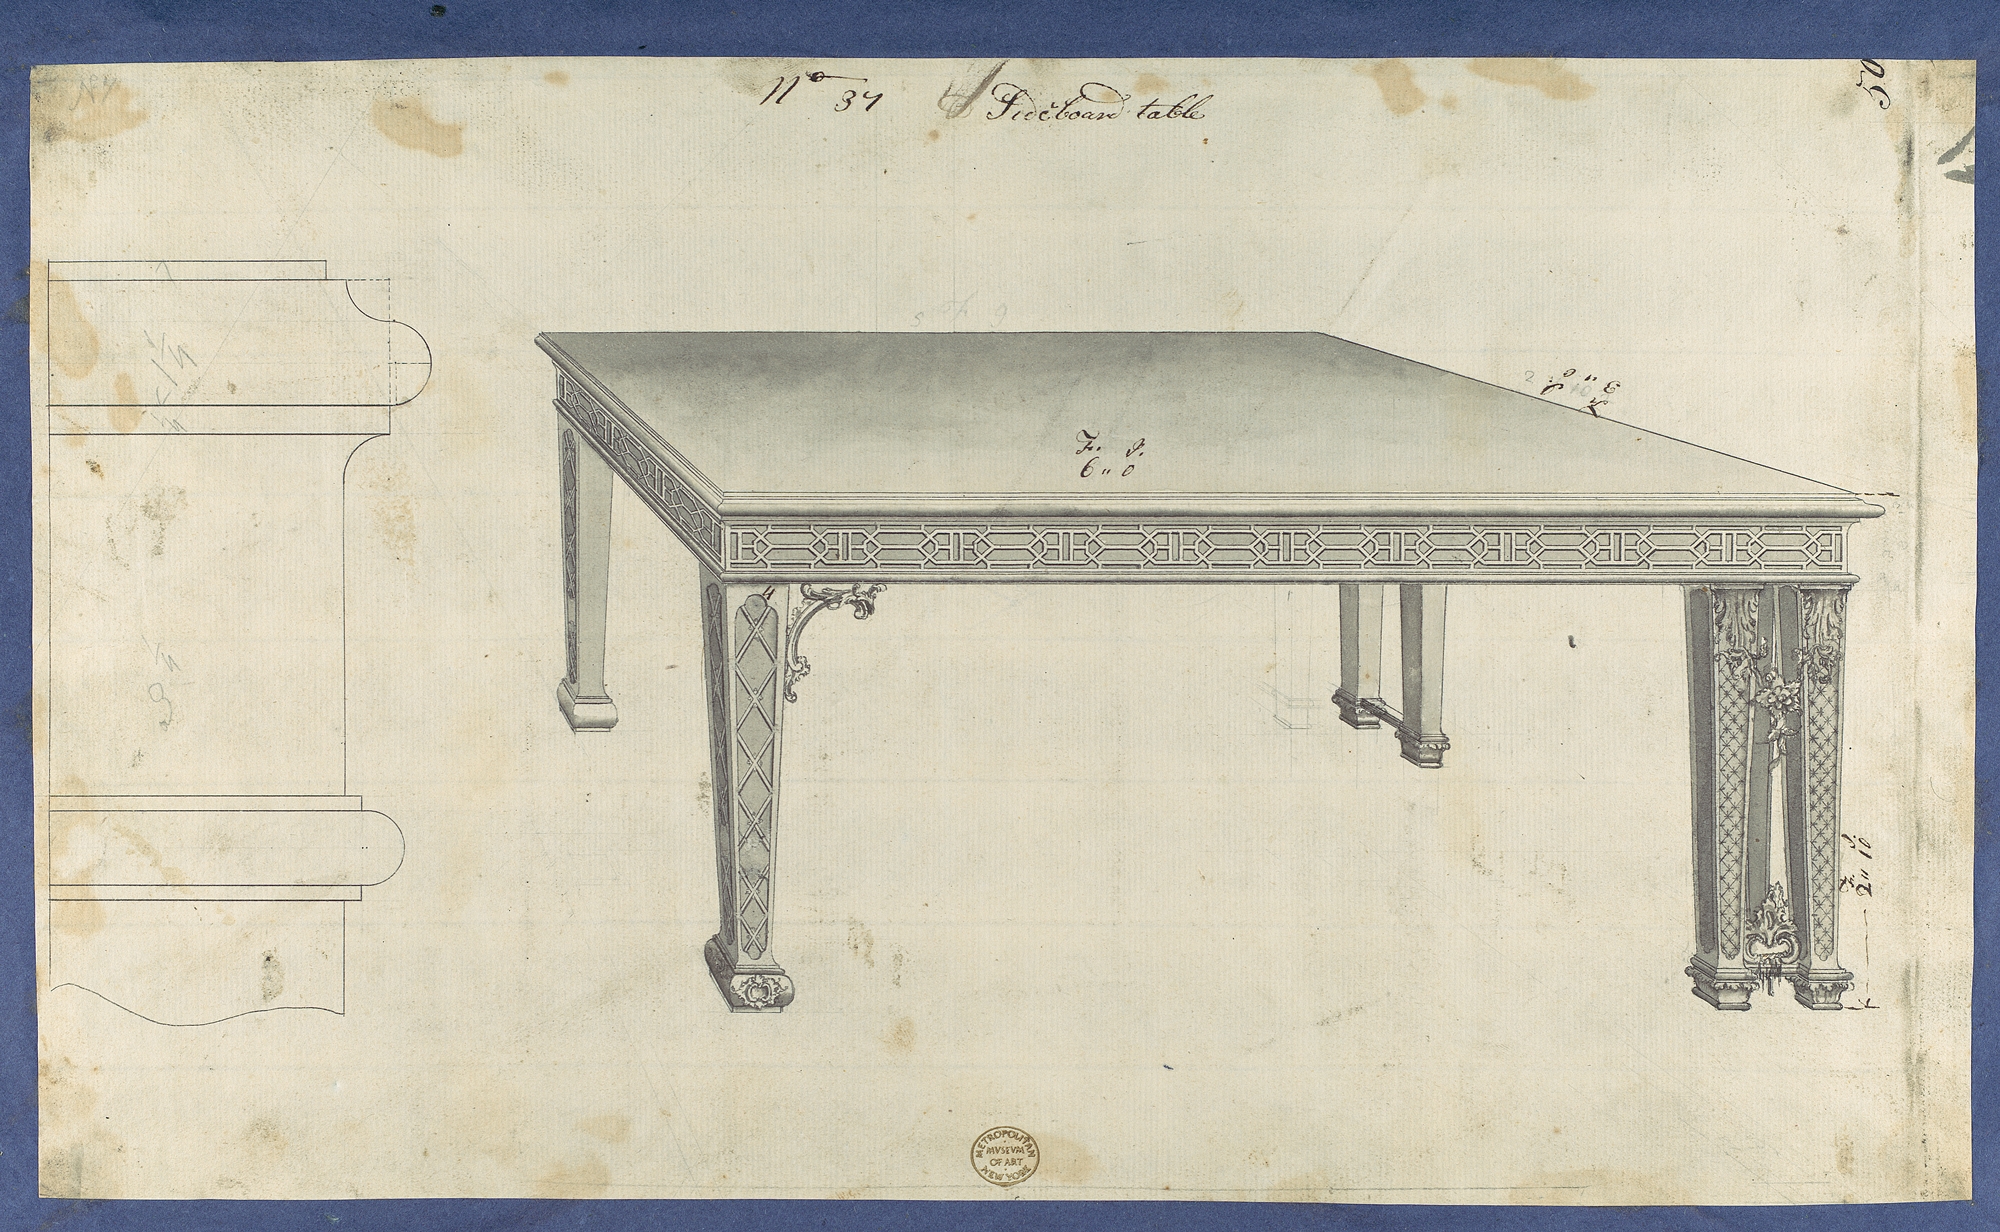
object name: drawing ornament architecture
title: Sideboard Table, from Chippendale Drawings, Vol. II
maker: thomas chippendale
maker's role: artist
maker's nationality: british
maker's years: 1718-1779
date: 1753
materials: ink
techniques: brush, wash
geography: london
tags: tables